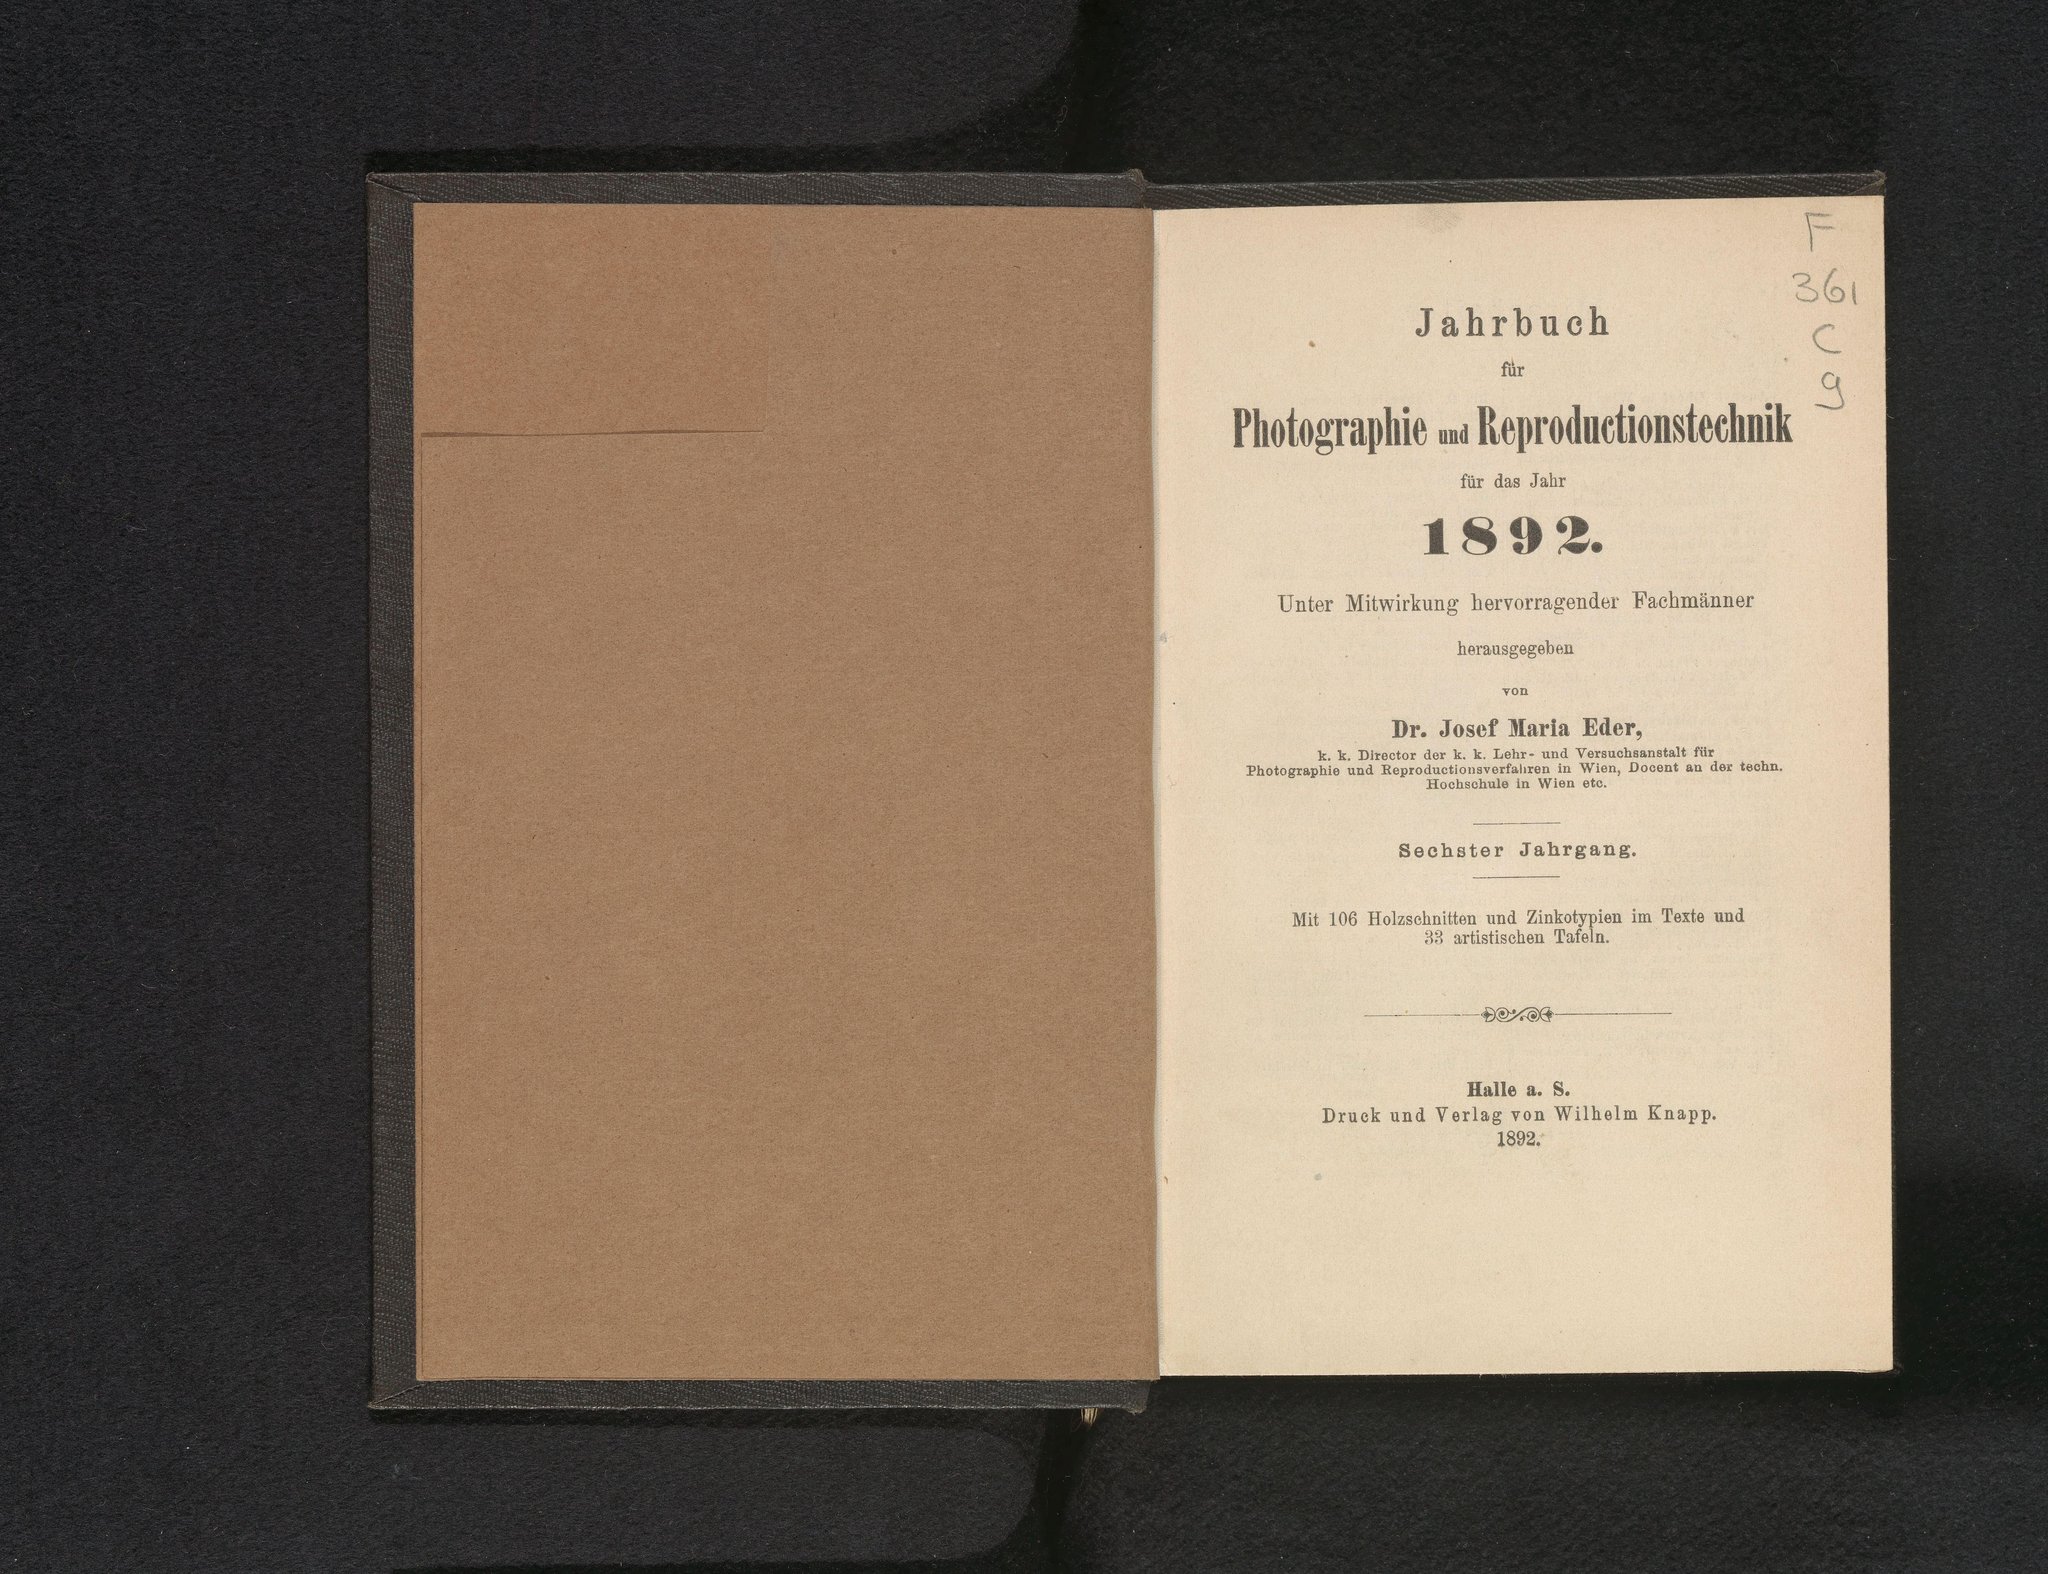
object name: book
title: Jahrbuch für Photographie und Reproduktionstechnik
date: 1892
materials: linen, paper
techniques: chromolithography, photograph, printing, printing block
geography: halle an der saale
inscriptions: date: ‘JUNE 1989’